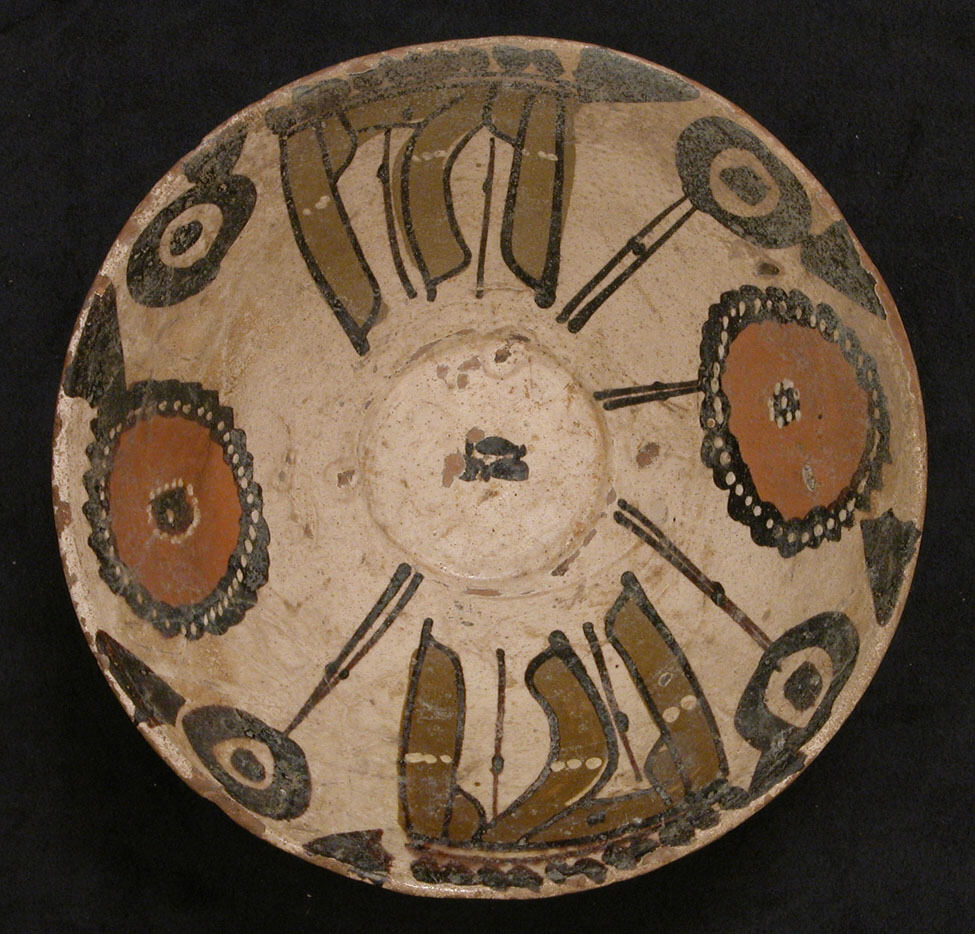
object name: bowl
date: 901-1000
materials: earthenware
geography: iran